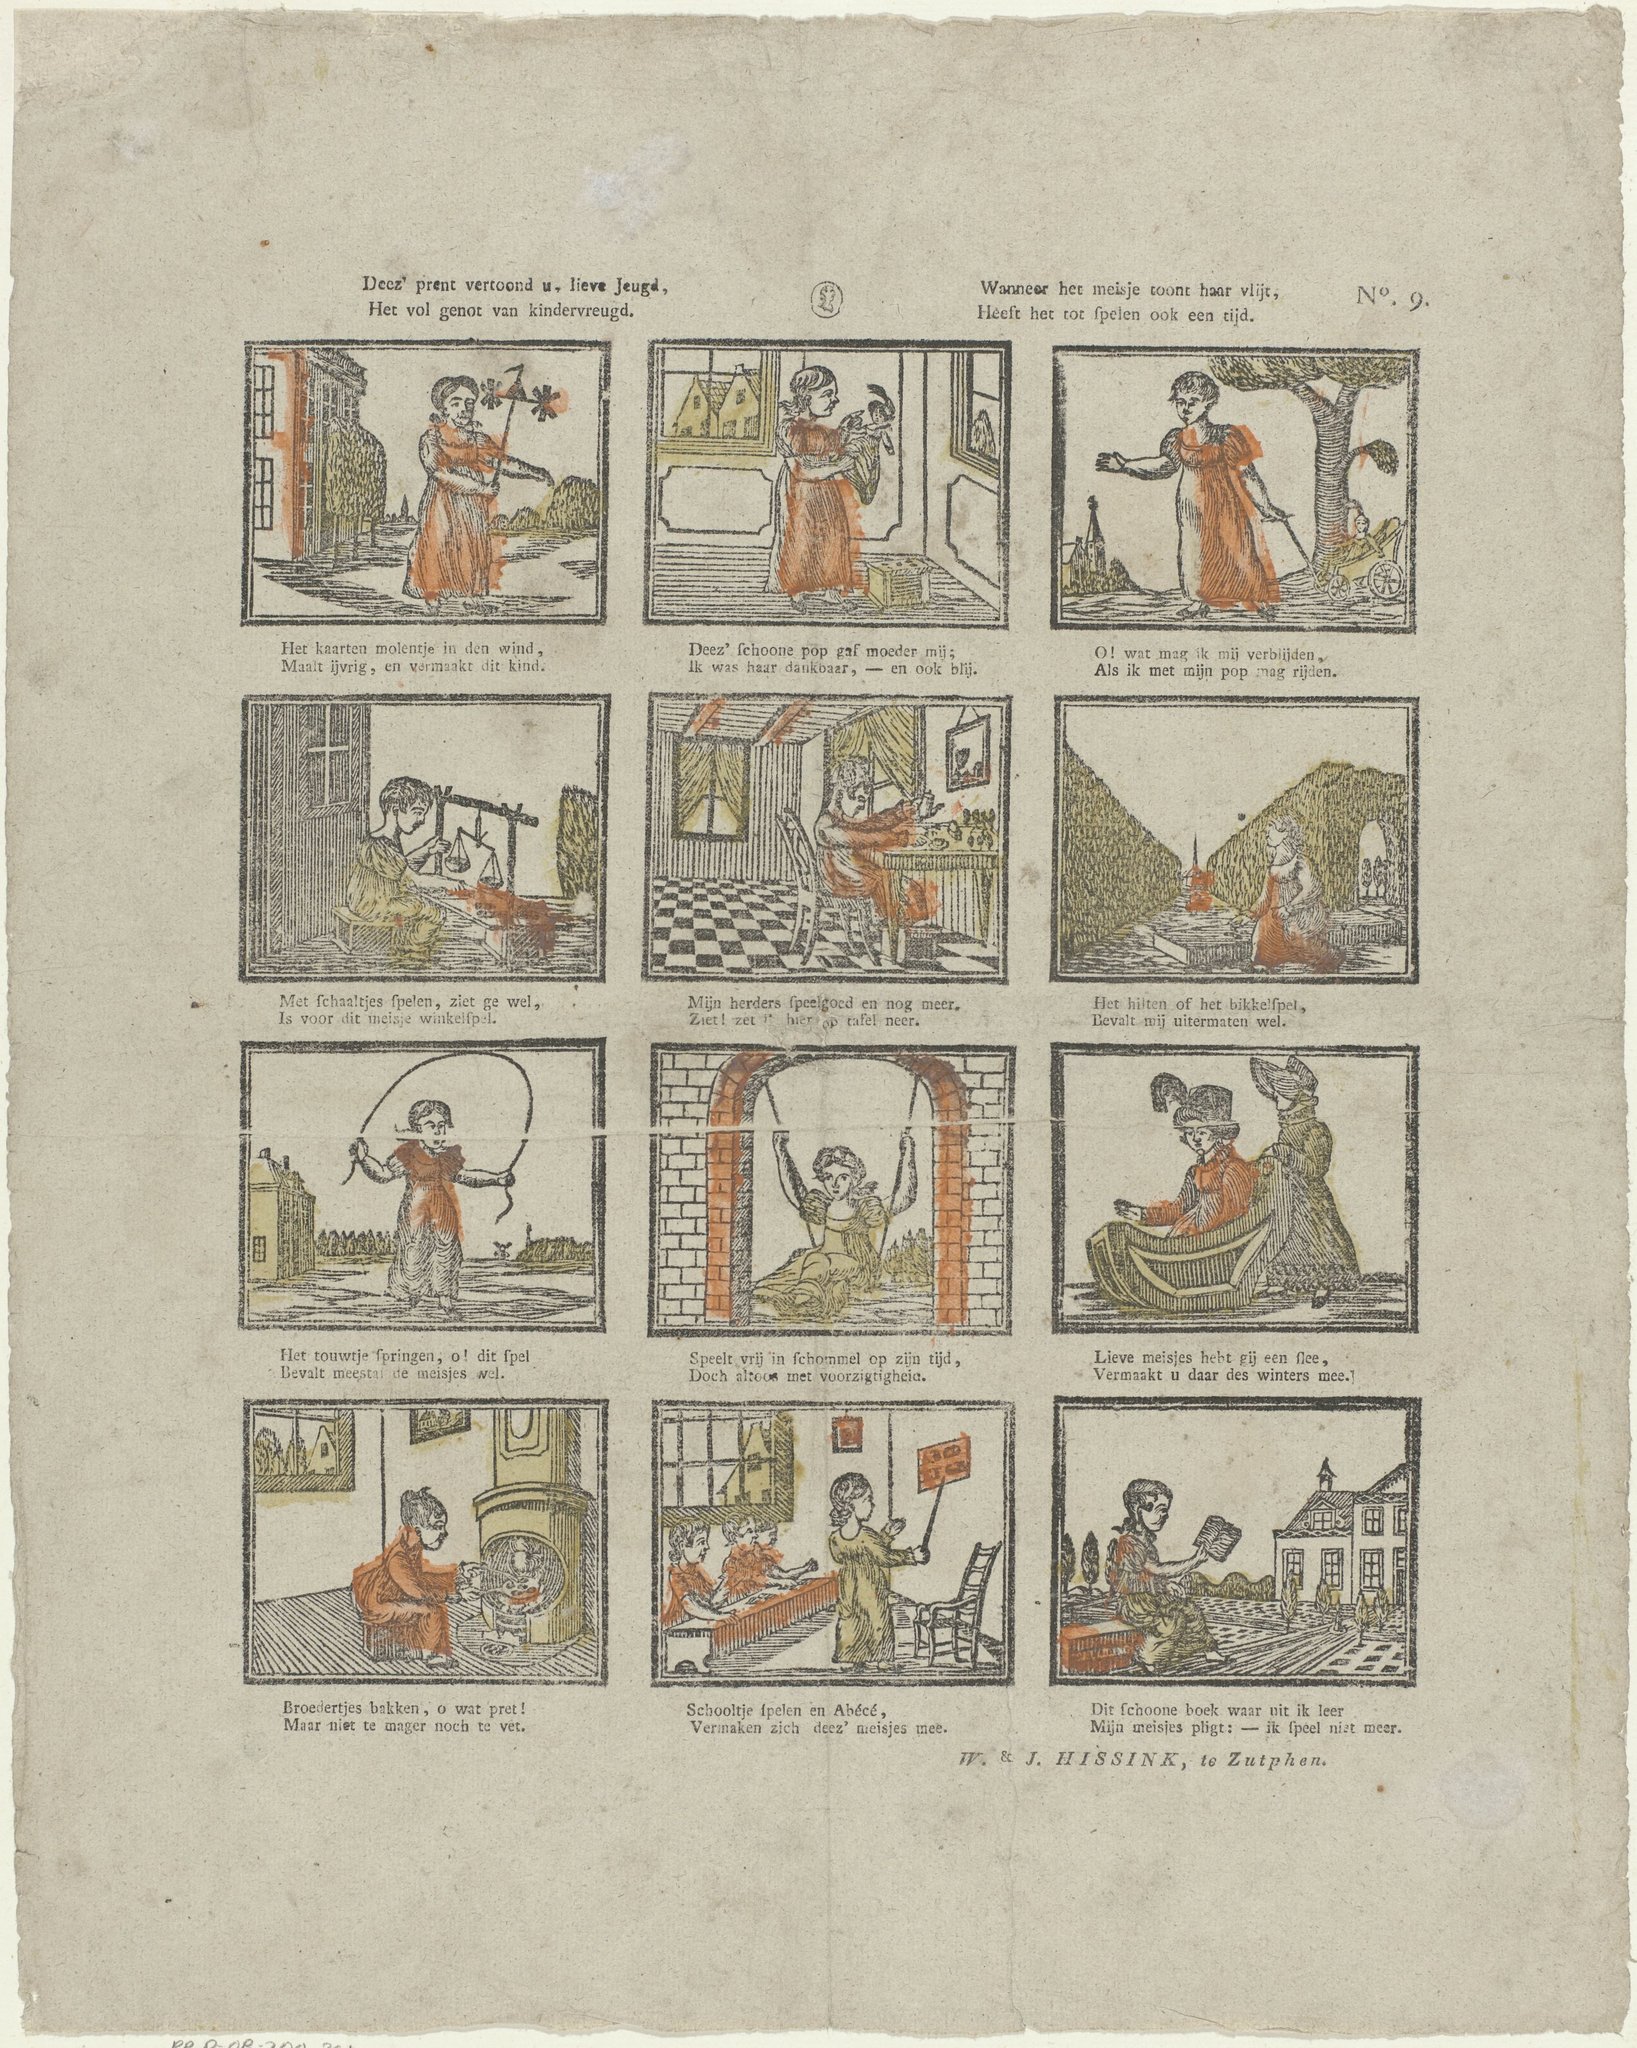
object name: print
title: Deez' prent vertoond u, lieve jeugd, / Het vol genot van kindervreugd. / Wanneer het meisje toont haar vlijt, / Heeft het tot spelen ook een tijd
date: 1820-1838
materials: paper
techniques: colour, letterpress printing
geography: zutphen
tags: children's games and plays, (playing with) dolls, jumping-rope games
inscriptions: collector's mark: Lugt 2760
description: Blad met 16 voorstellingen spelende meisjes, zoals spelen met poppen, touwtjespringen en schooltje spelen. Onder elke afbeelding een tweeregelig vers. Genummerd rechtsboven: No. 9.